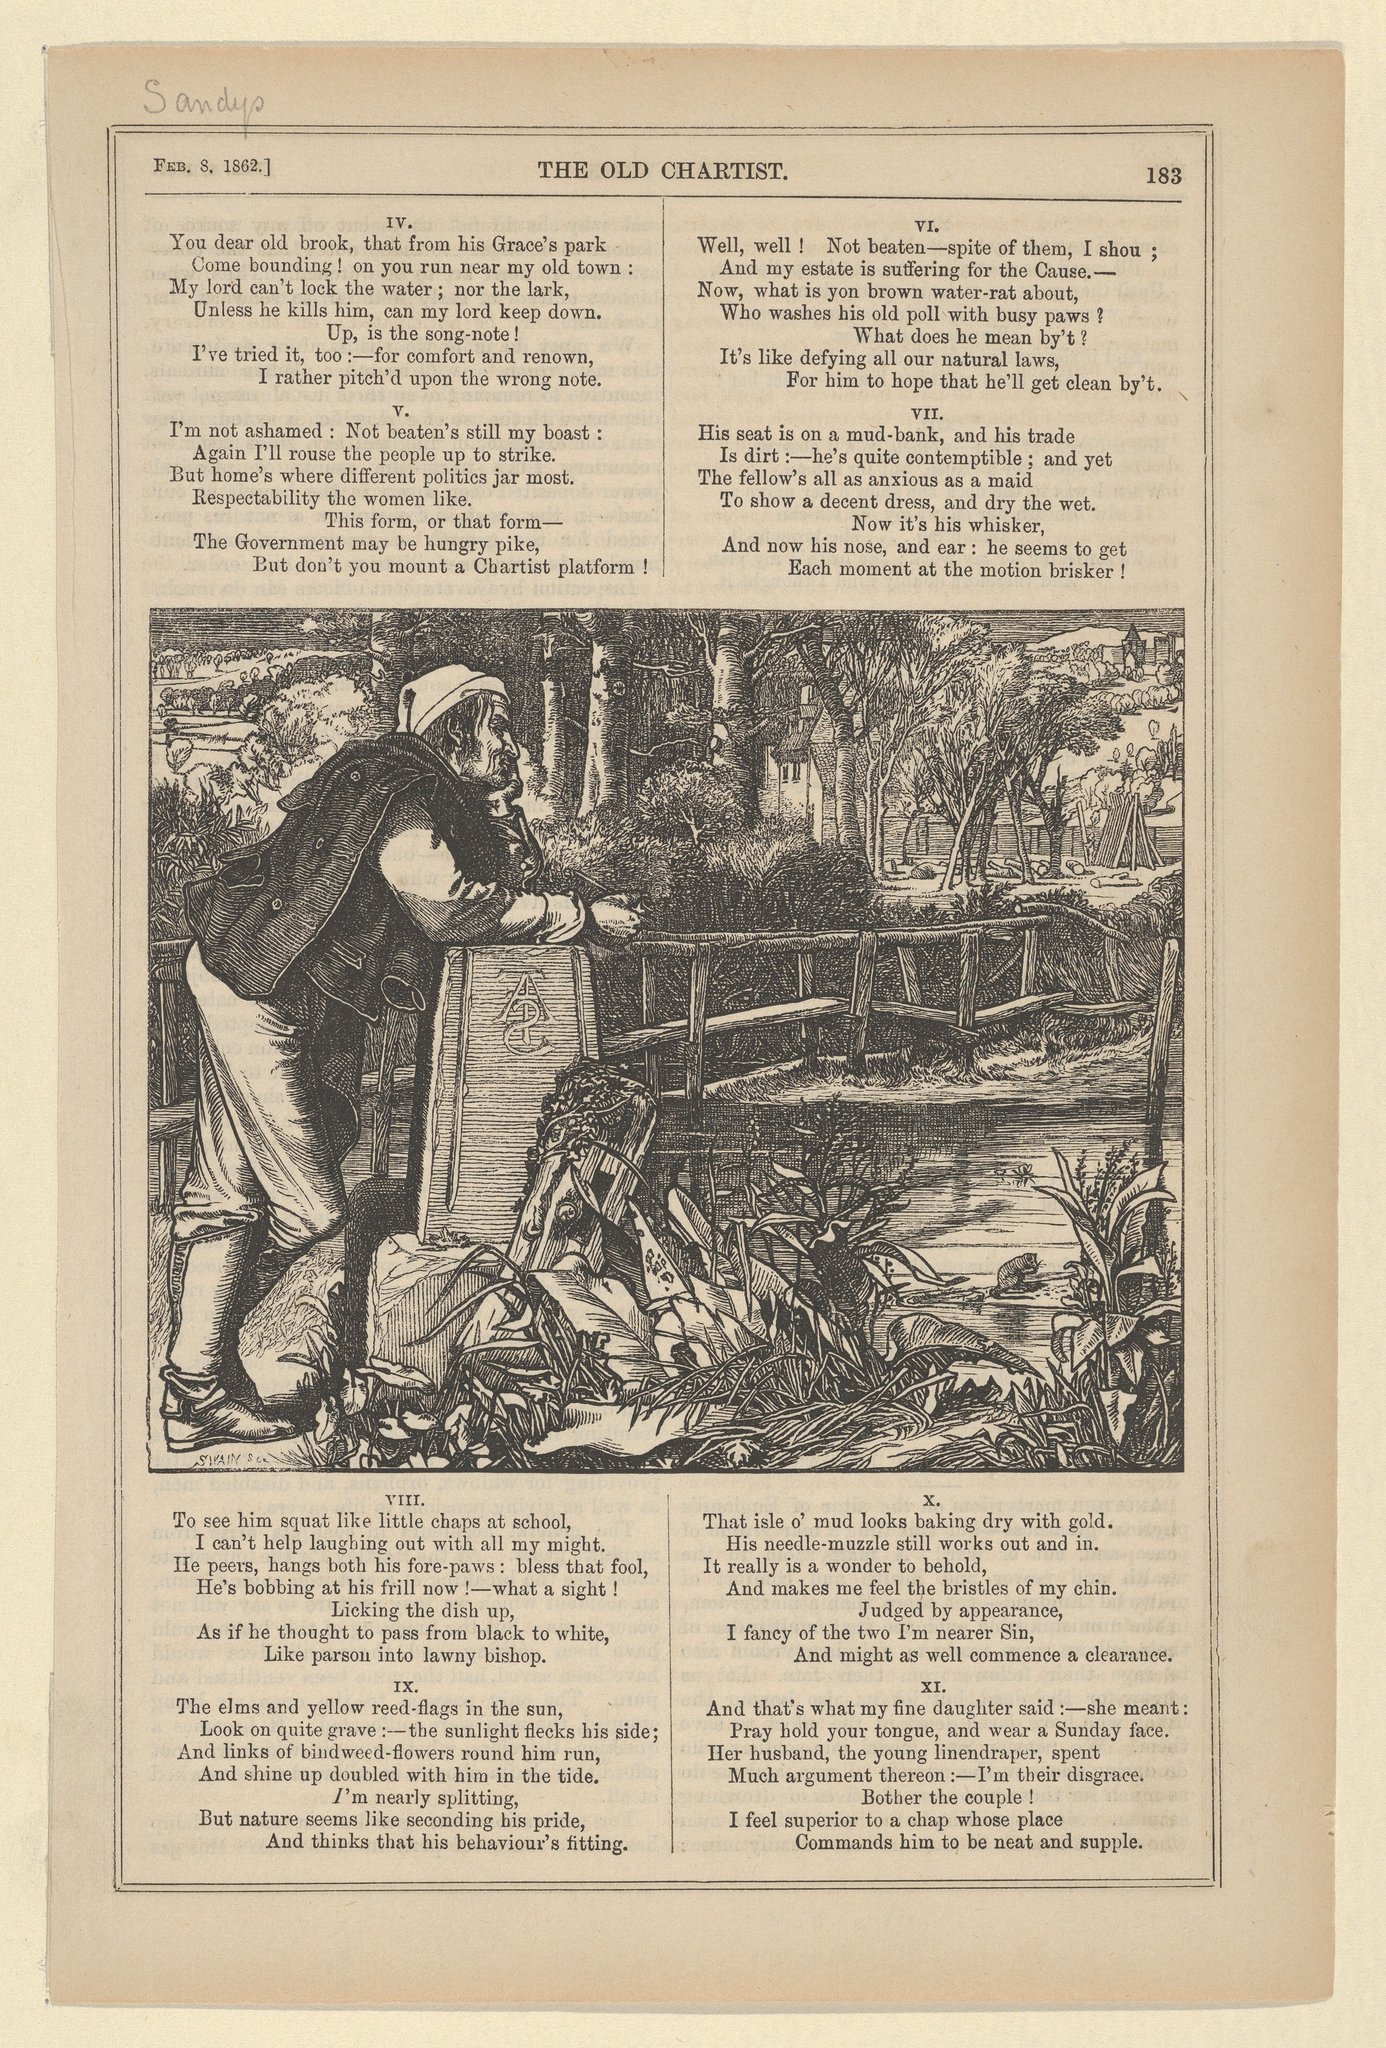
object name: print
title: The Old Chartist ("Once a Week," vol. 6, p. 183)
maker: frederick augustus sandys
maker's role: artist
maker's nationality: british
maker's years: 1829-1904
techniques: engraving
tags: men